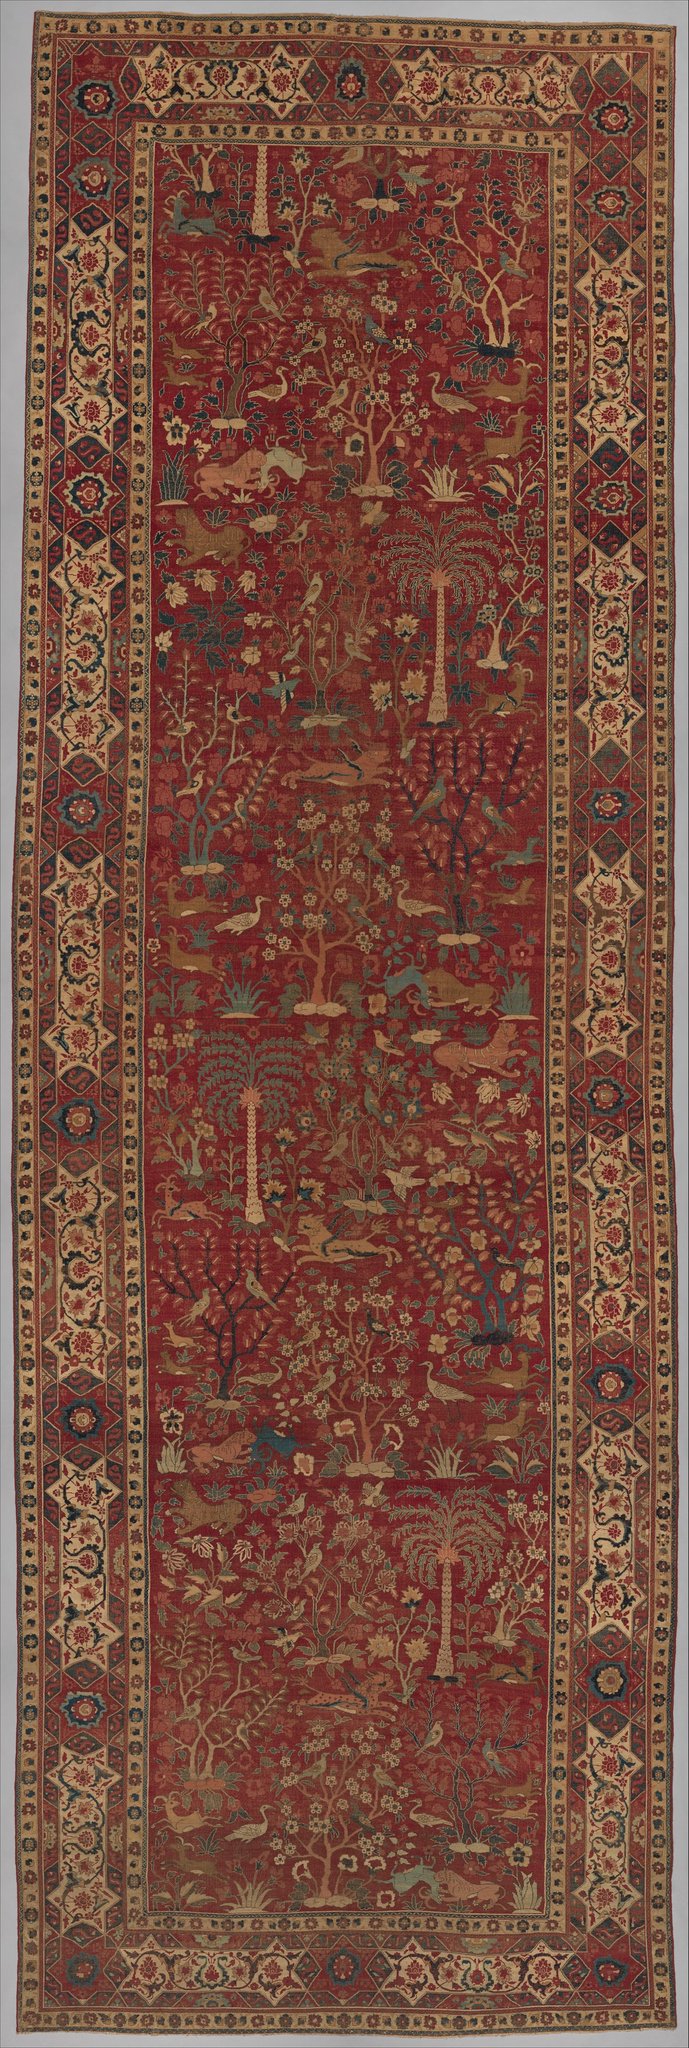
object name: carpet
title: Carpet with Palm Trees, Ibexes, and Birds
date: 1567-1633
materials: cotton, wool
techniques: asymmetrically knotted pile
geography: pakistan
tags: birds,lions,tigers,flowers,palms,ibex